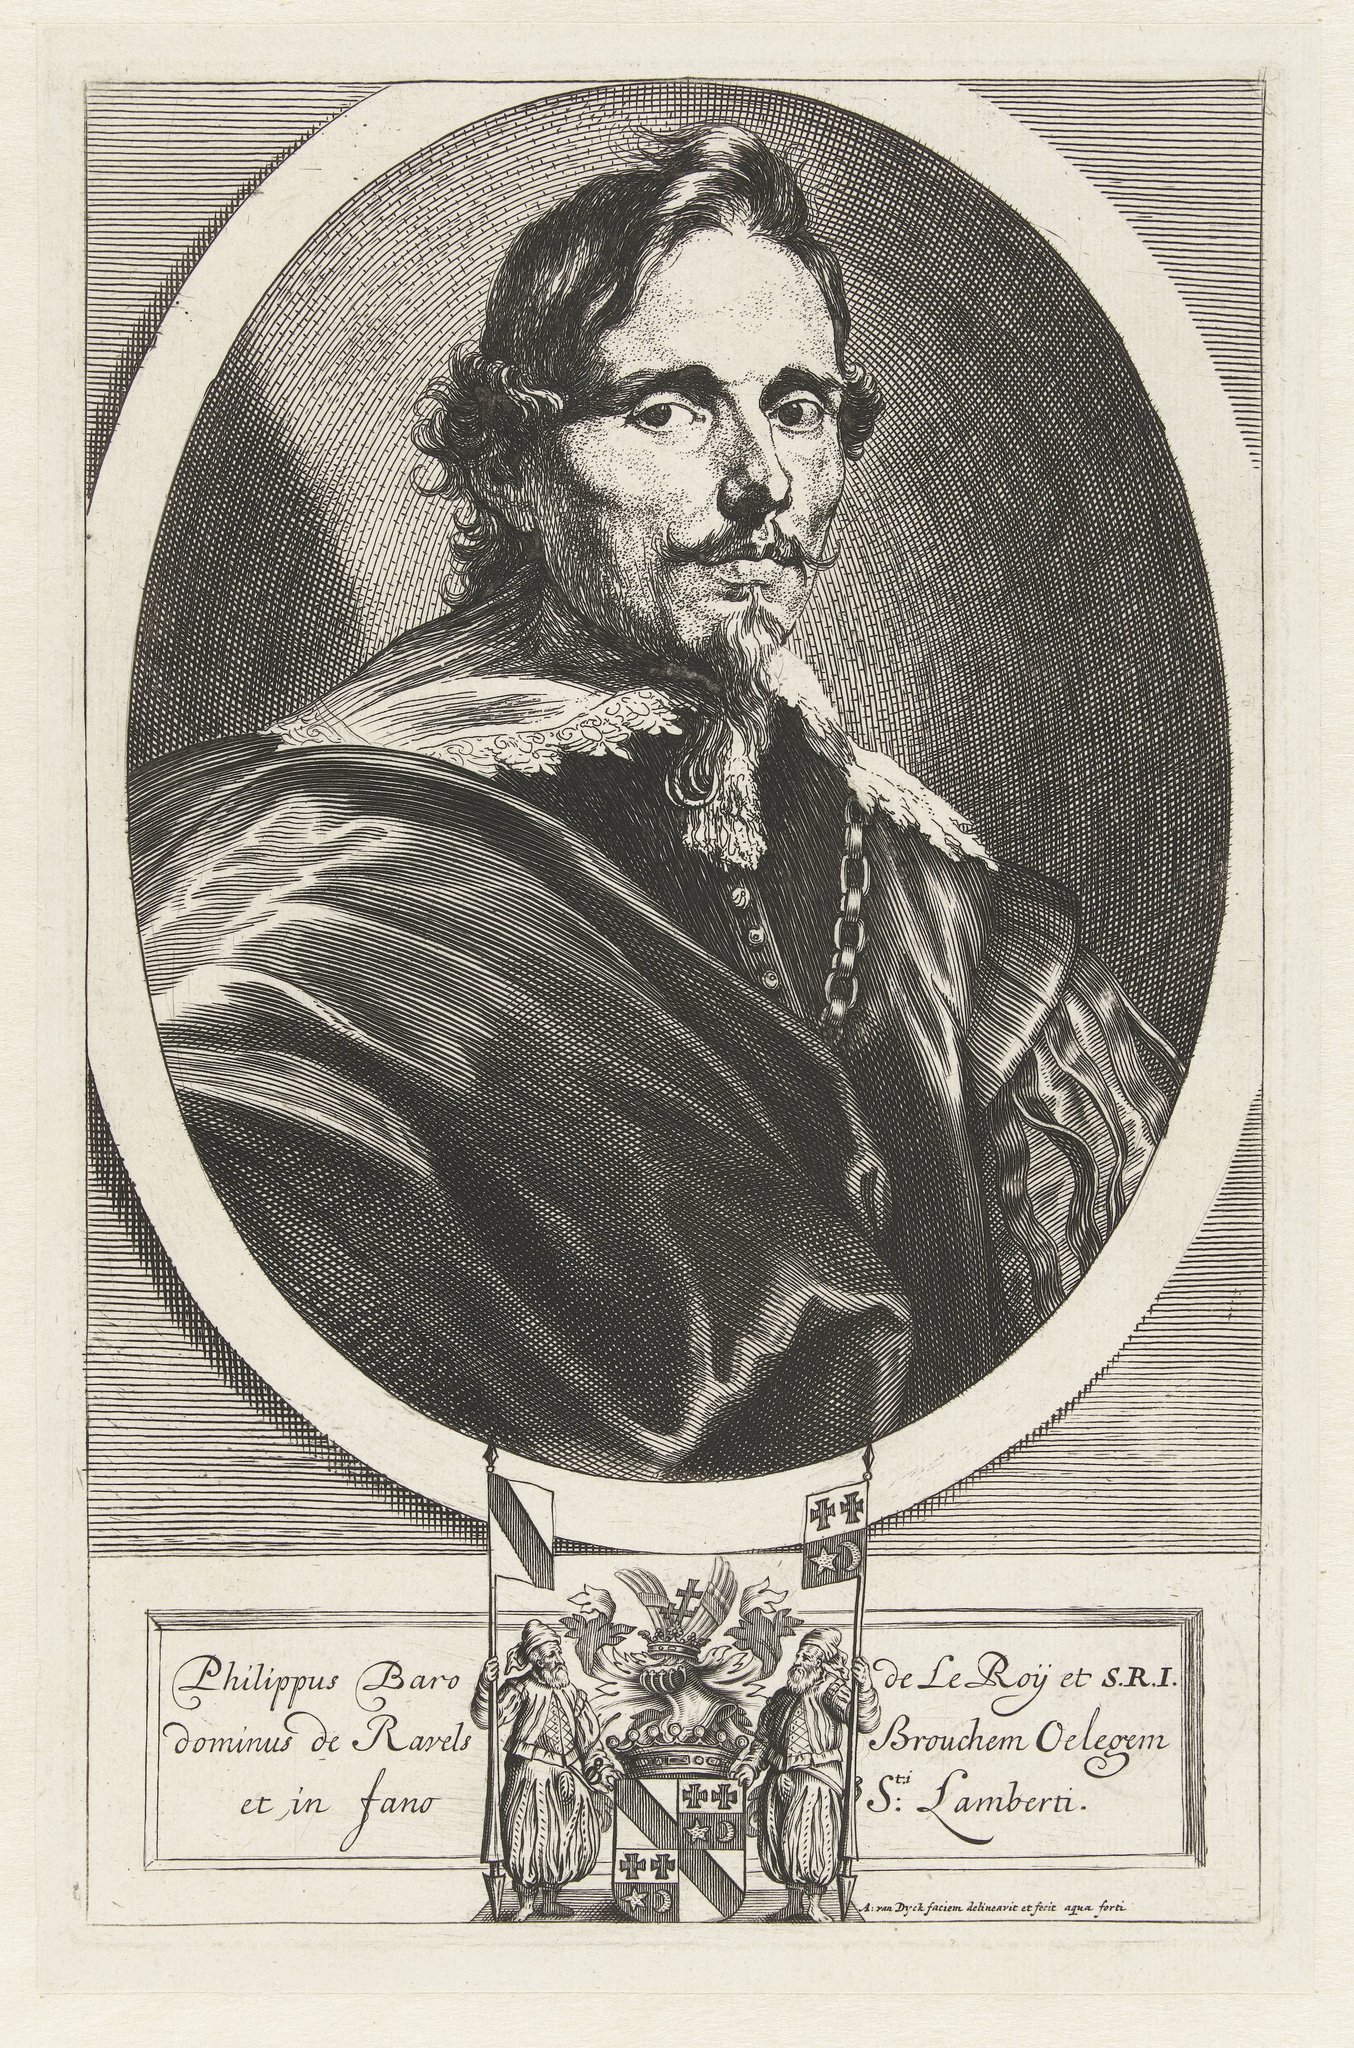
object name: print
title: Portret van de verzamelaar en diplomaat Philippe Le Roy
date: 1630-1632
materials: paper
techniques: engraving, etching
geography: low countries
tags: art collector, diplomacy, diplomat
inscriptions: collector's mark: Lugt 240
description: Portret van de kunstverzamelaar en diplomaat Philippe Le Roy, Heer van Ravels, baron van Broechem, raadsheer van koning Filips IV van Spanje. Portret in ovale omlijsting met daaronder zijn wapen en naam en titulatuur in rechthoekig kader.